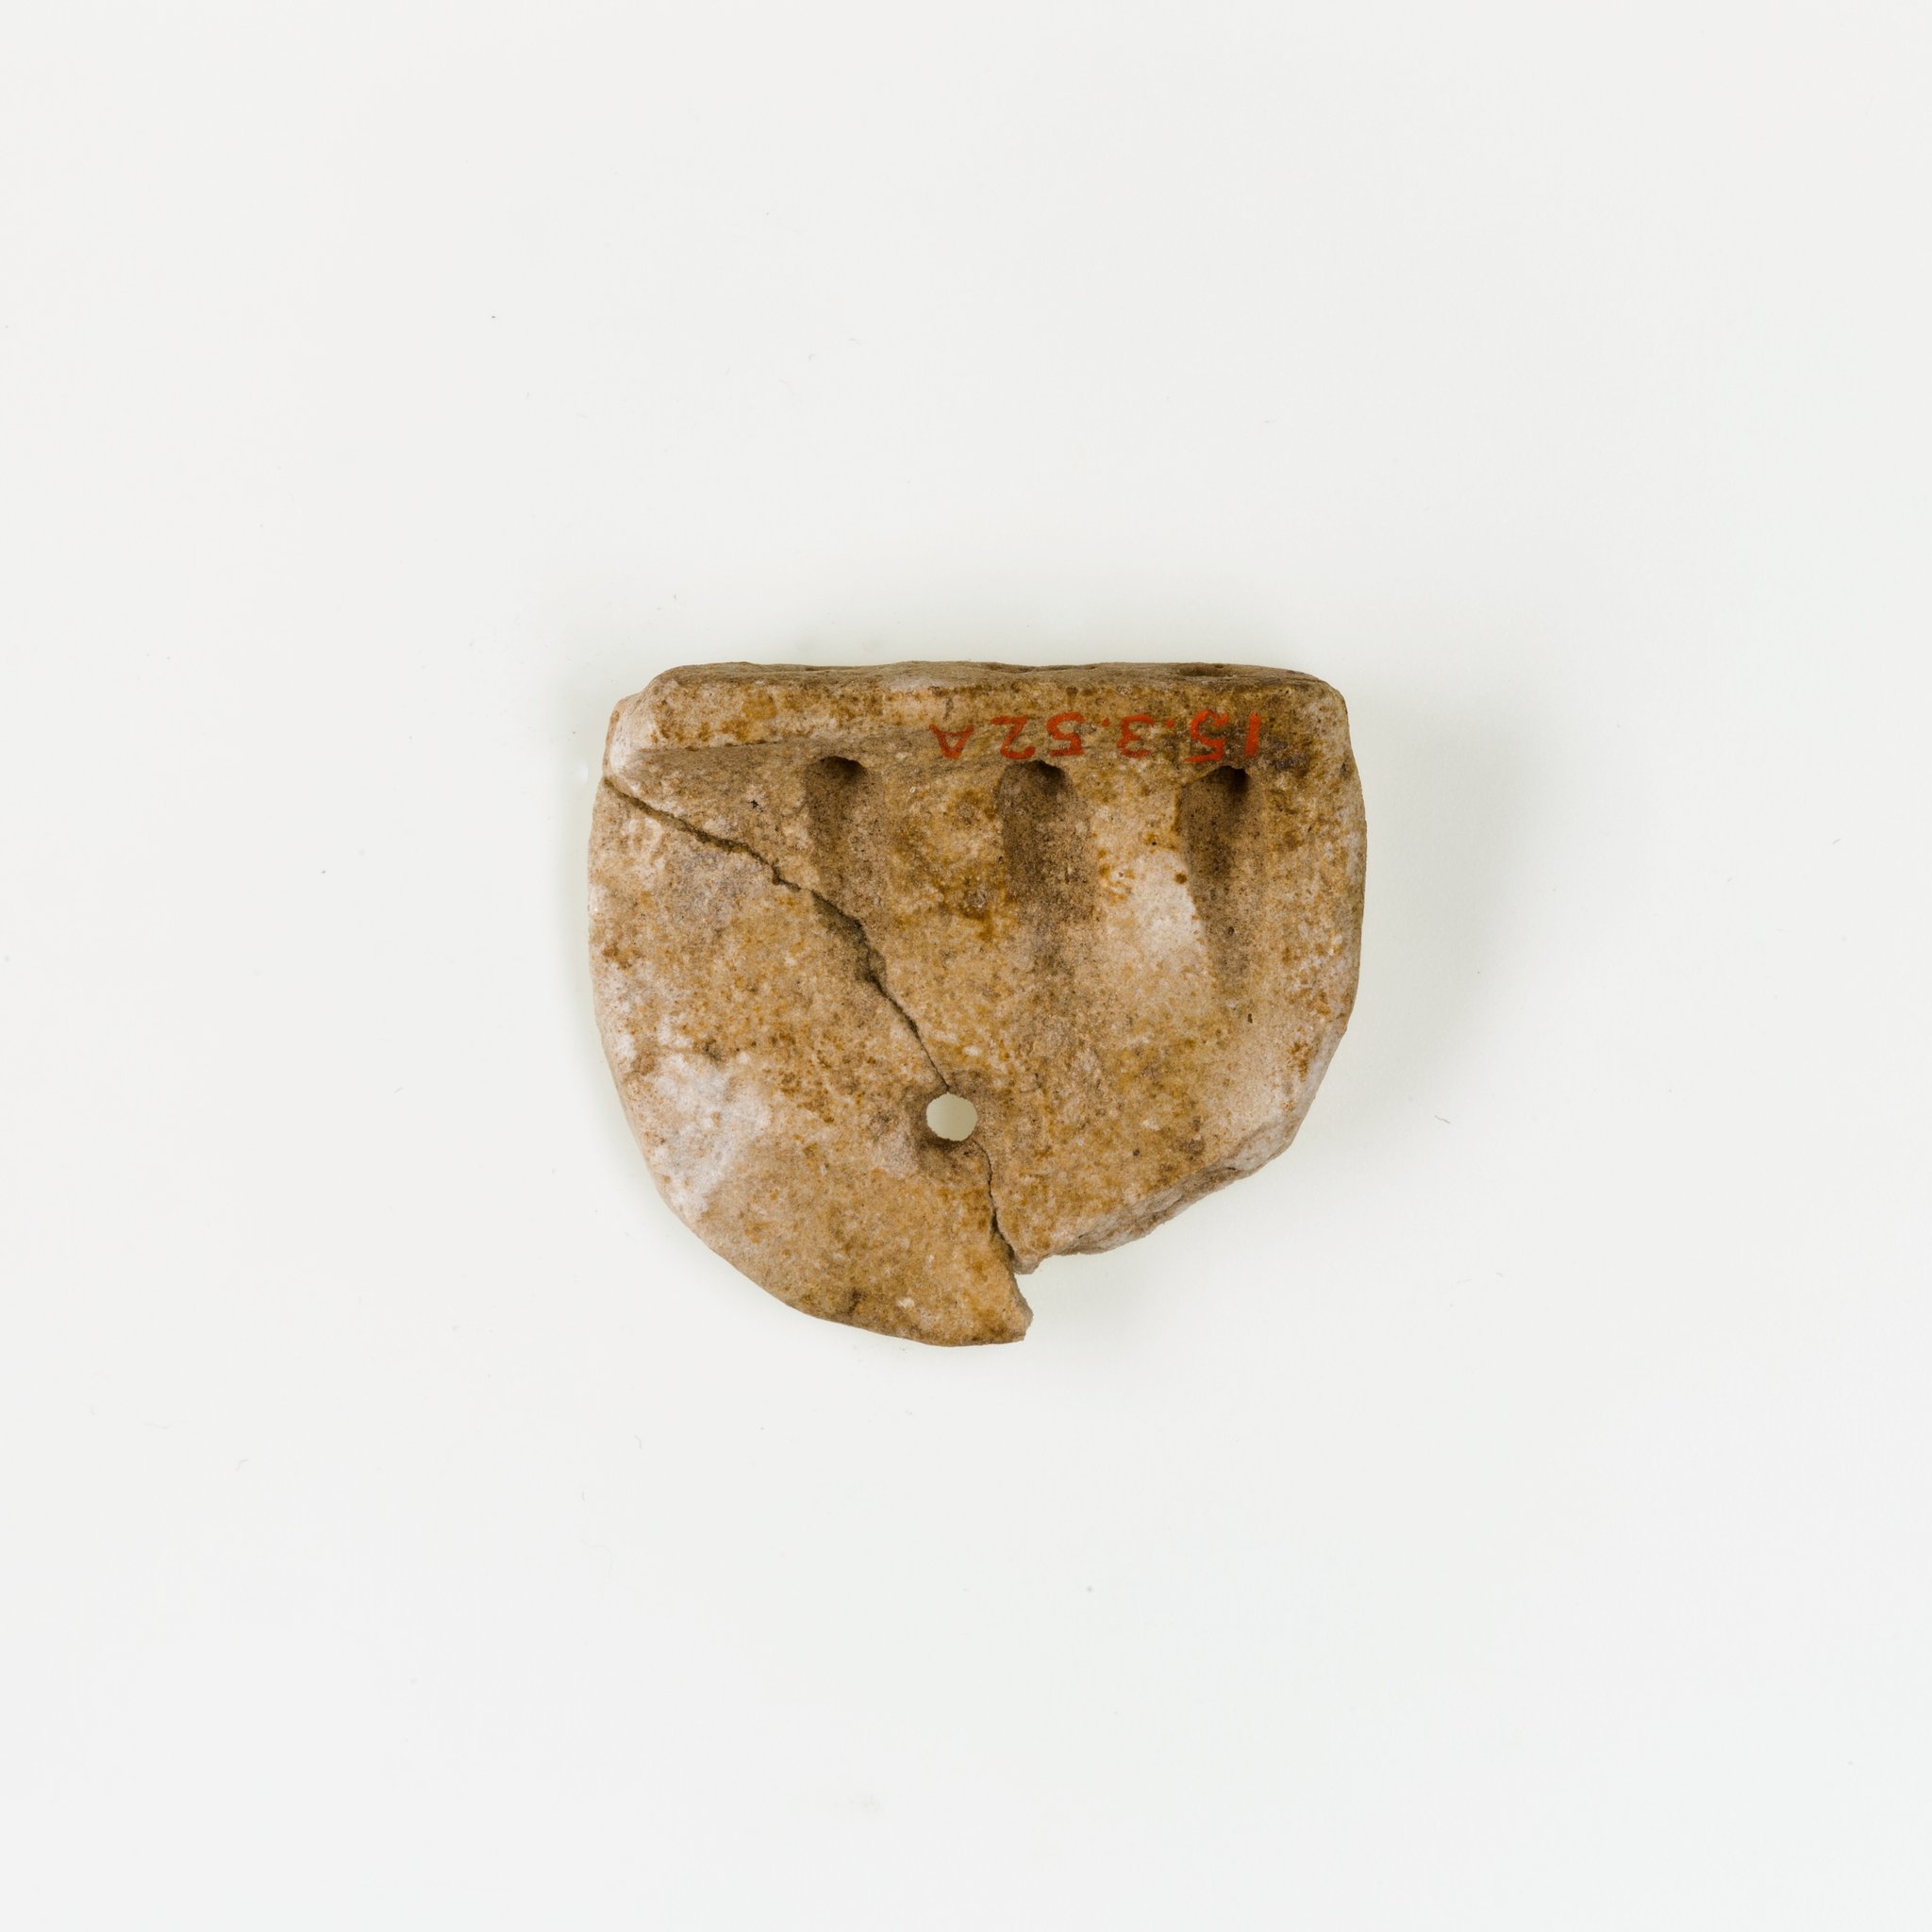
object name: broad collar piece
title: Broad Collar piece (?)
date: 1850-1640 BCE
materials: faience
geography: egypt